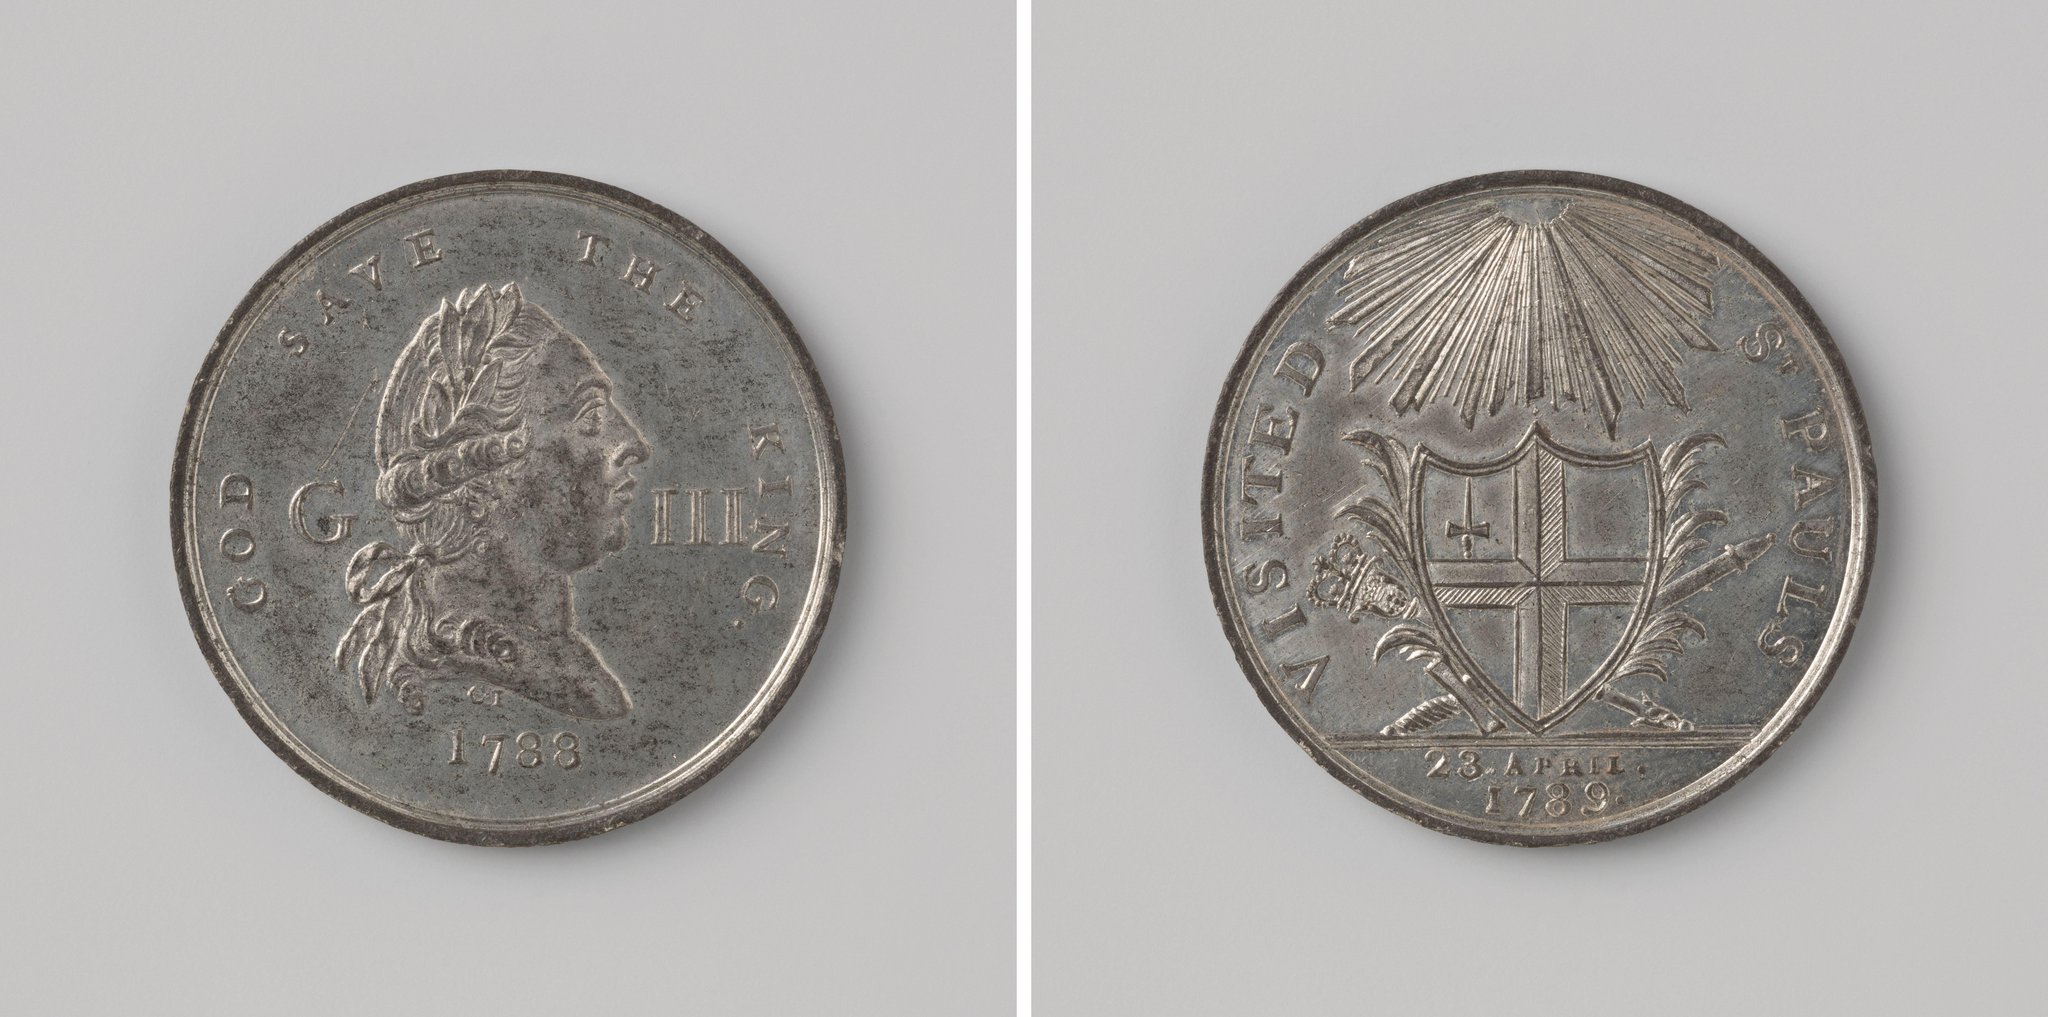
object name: history medal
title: Bezoek van George III, koning van Engeland aan Sint Paul's Cathedral na zijn herstel van een ziekte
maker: charles james (medailleur)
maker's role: graveur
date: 1788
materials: silver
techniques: striking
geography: england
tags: london, george iii (koning van het verenigd koninkrijk)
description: Zilveren penning. Voorzijde: borststuk man met lauwerkrans tussen monogram binnen omschrift. Keerzijde: wapenschild voor scepter en zwaard tussen palmtakken, beschenen door hemellicht binnen omschrift; afsnede: datering